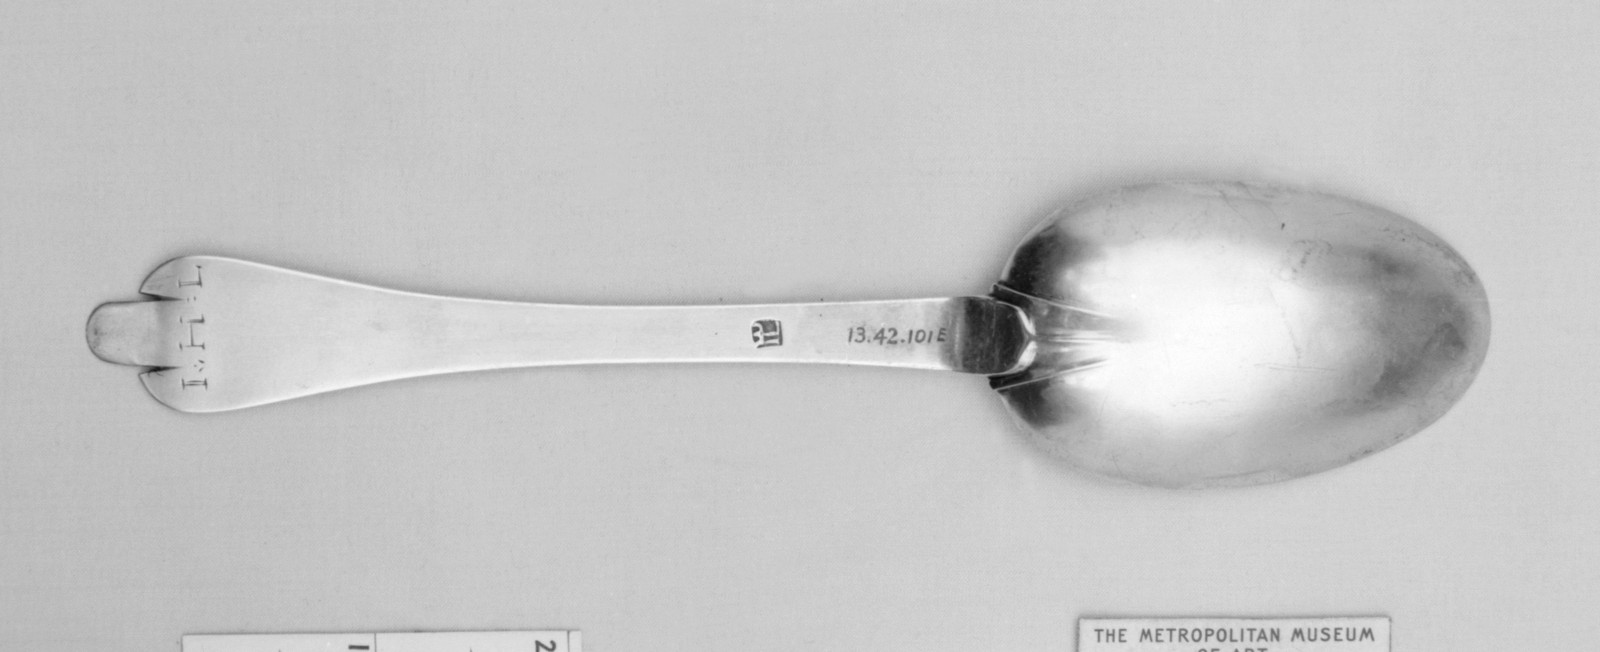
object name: spoon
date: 1667-1733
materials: silver